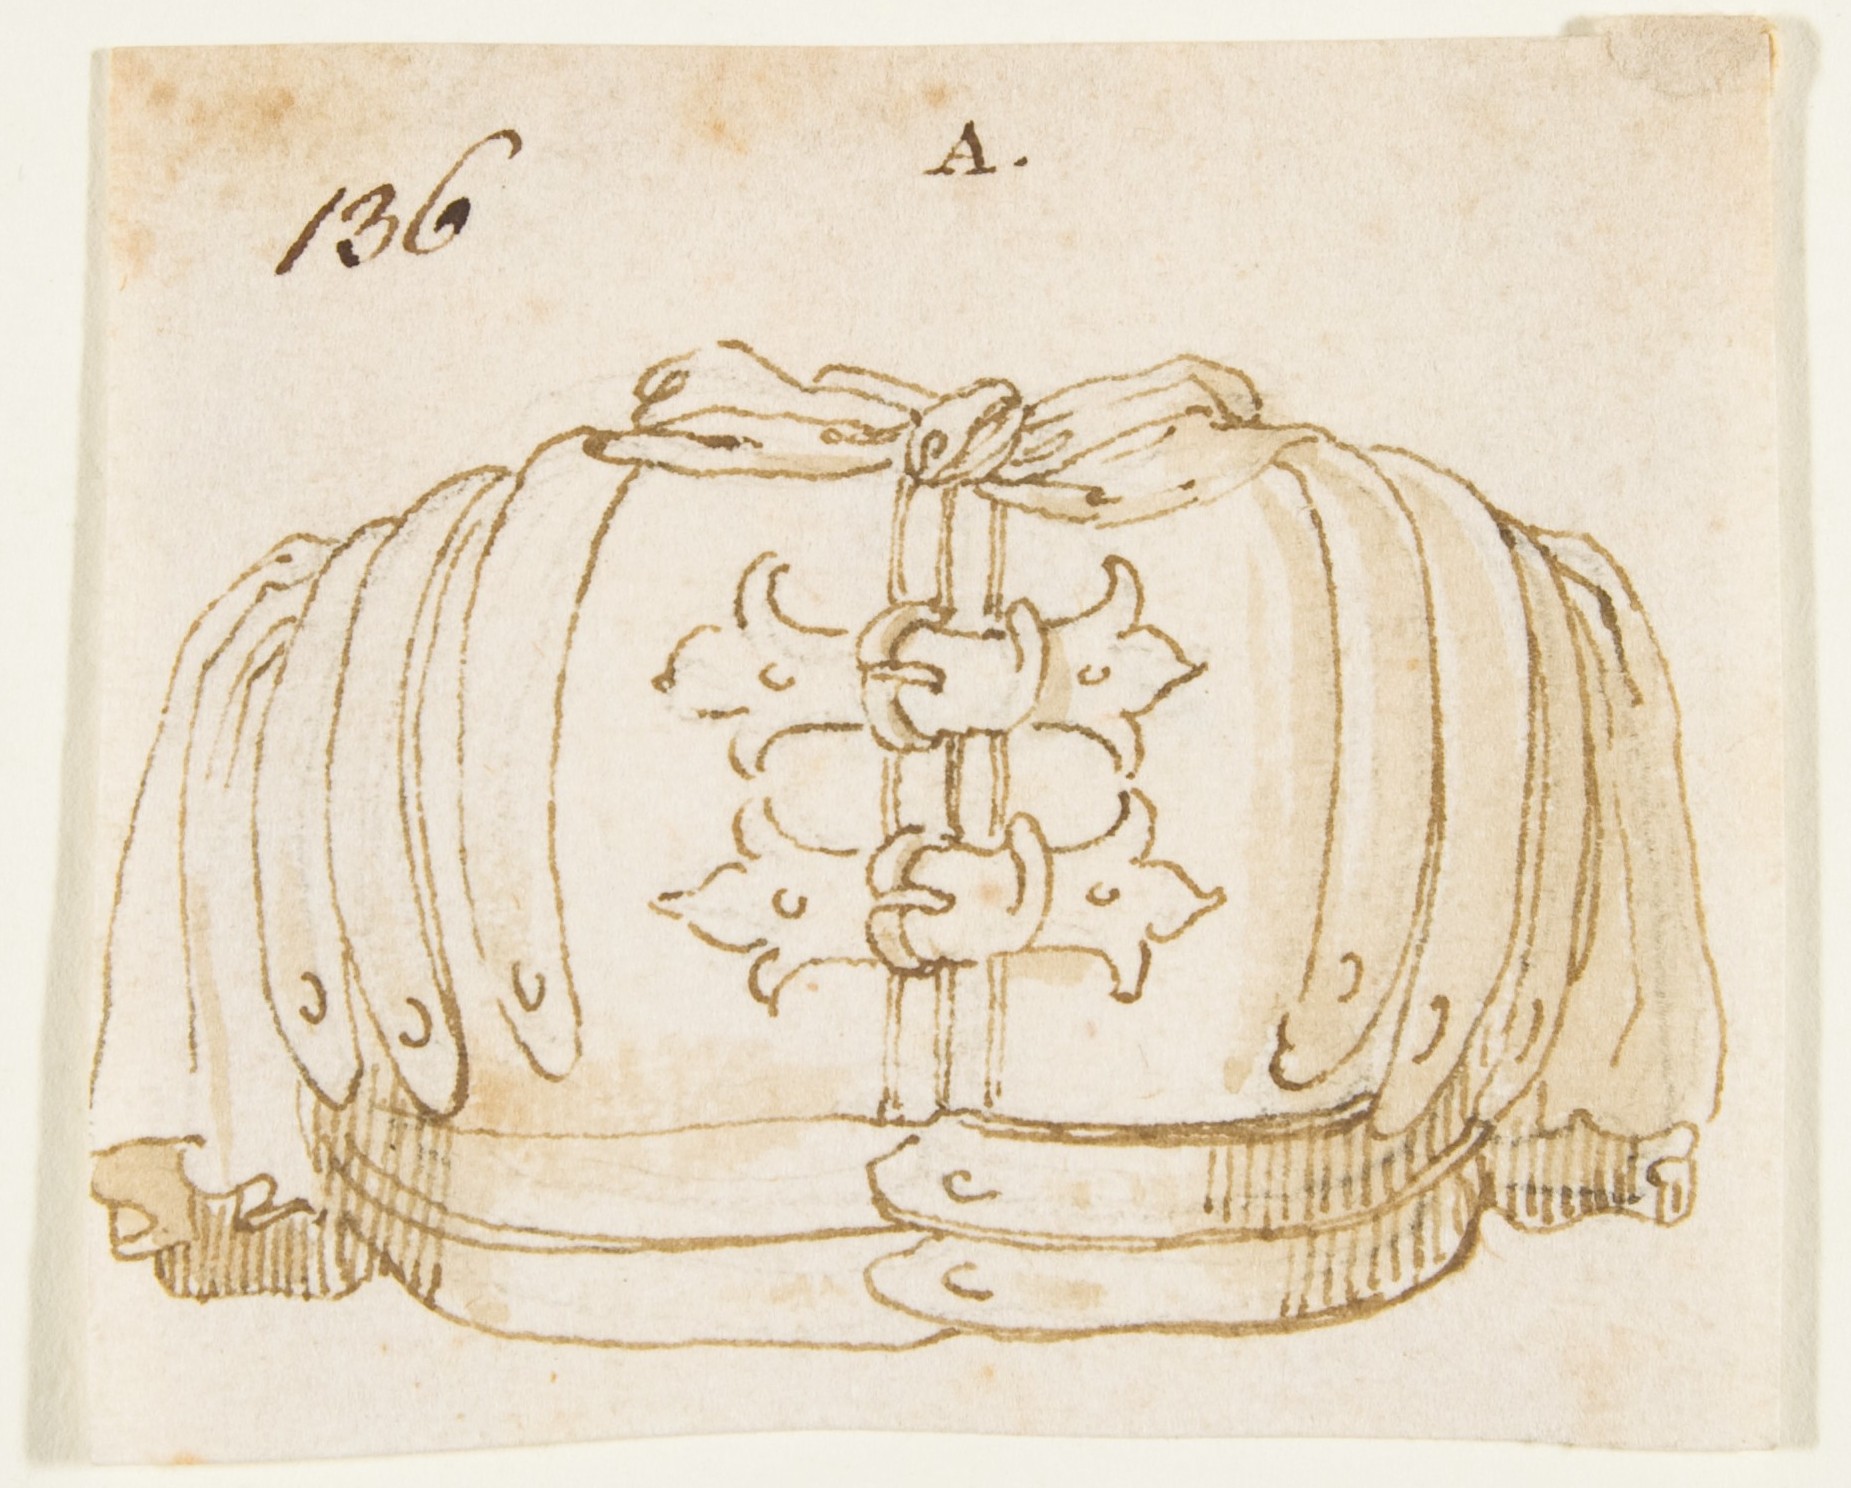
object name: drawing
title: Antique Armor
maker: anonymous, french, 19th century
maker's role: artist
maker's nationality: french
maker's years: 1800-1900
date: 1801-1900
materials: ink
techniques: pen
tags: armor